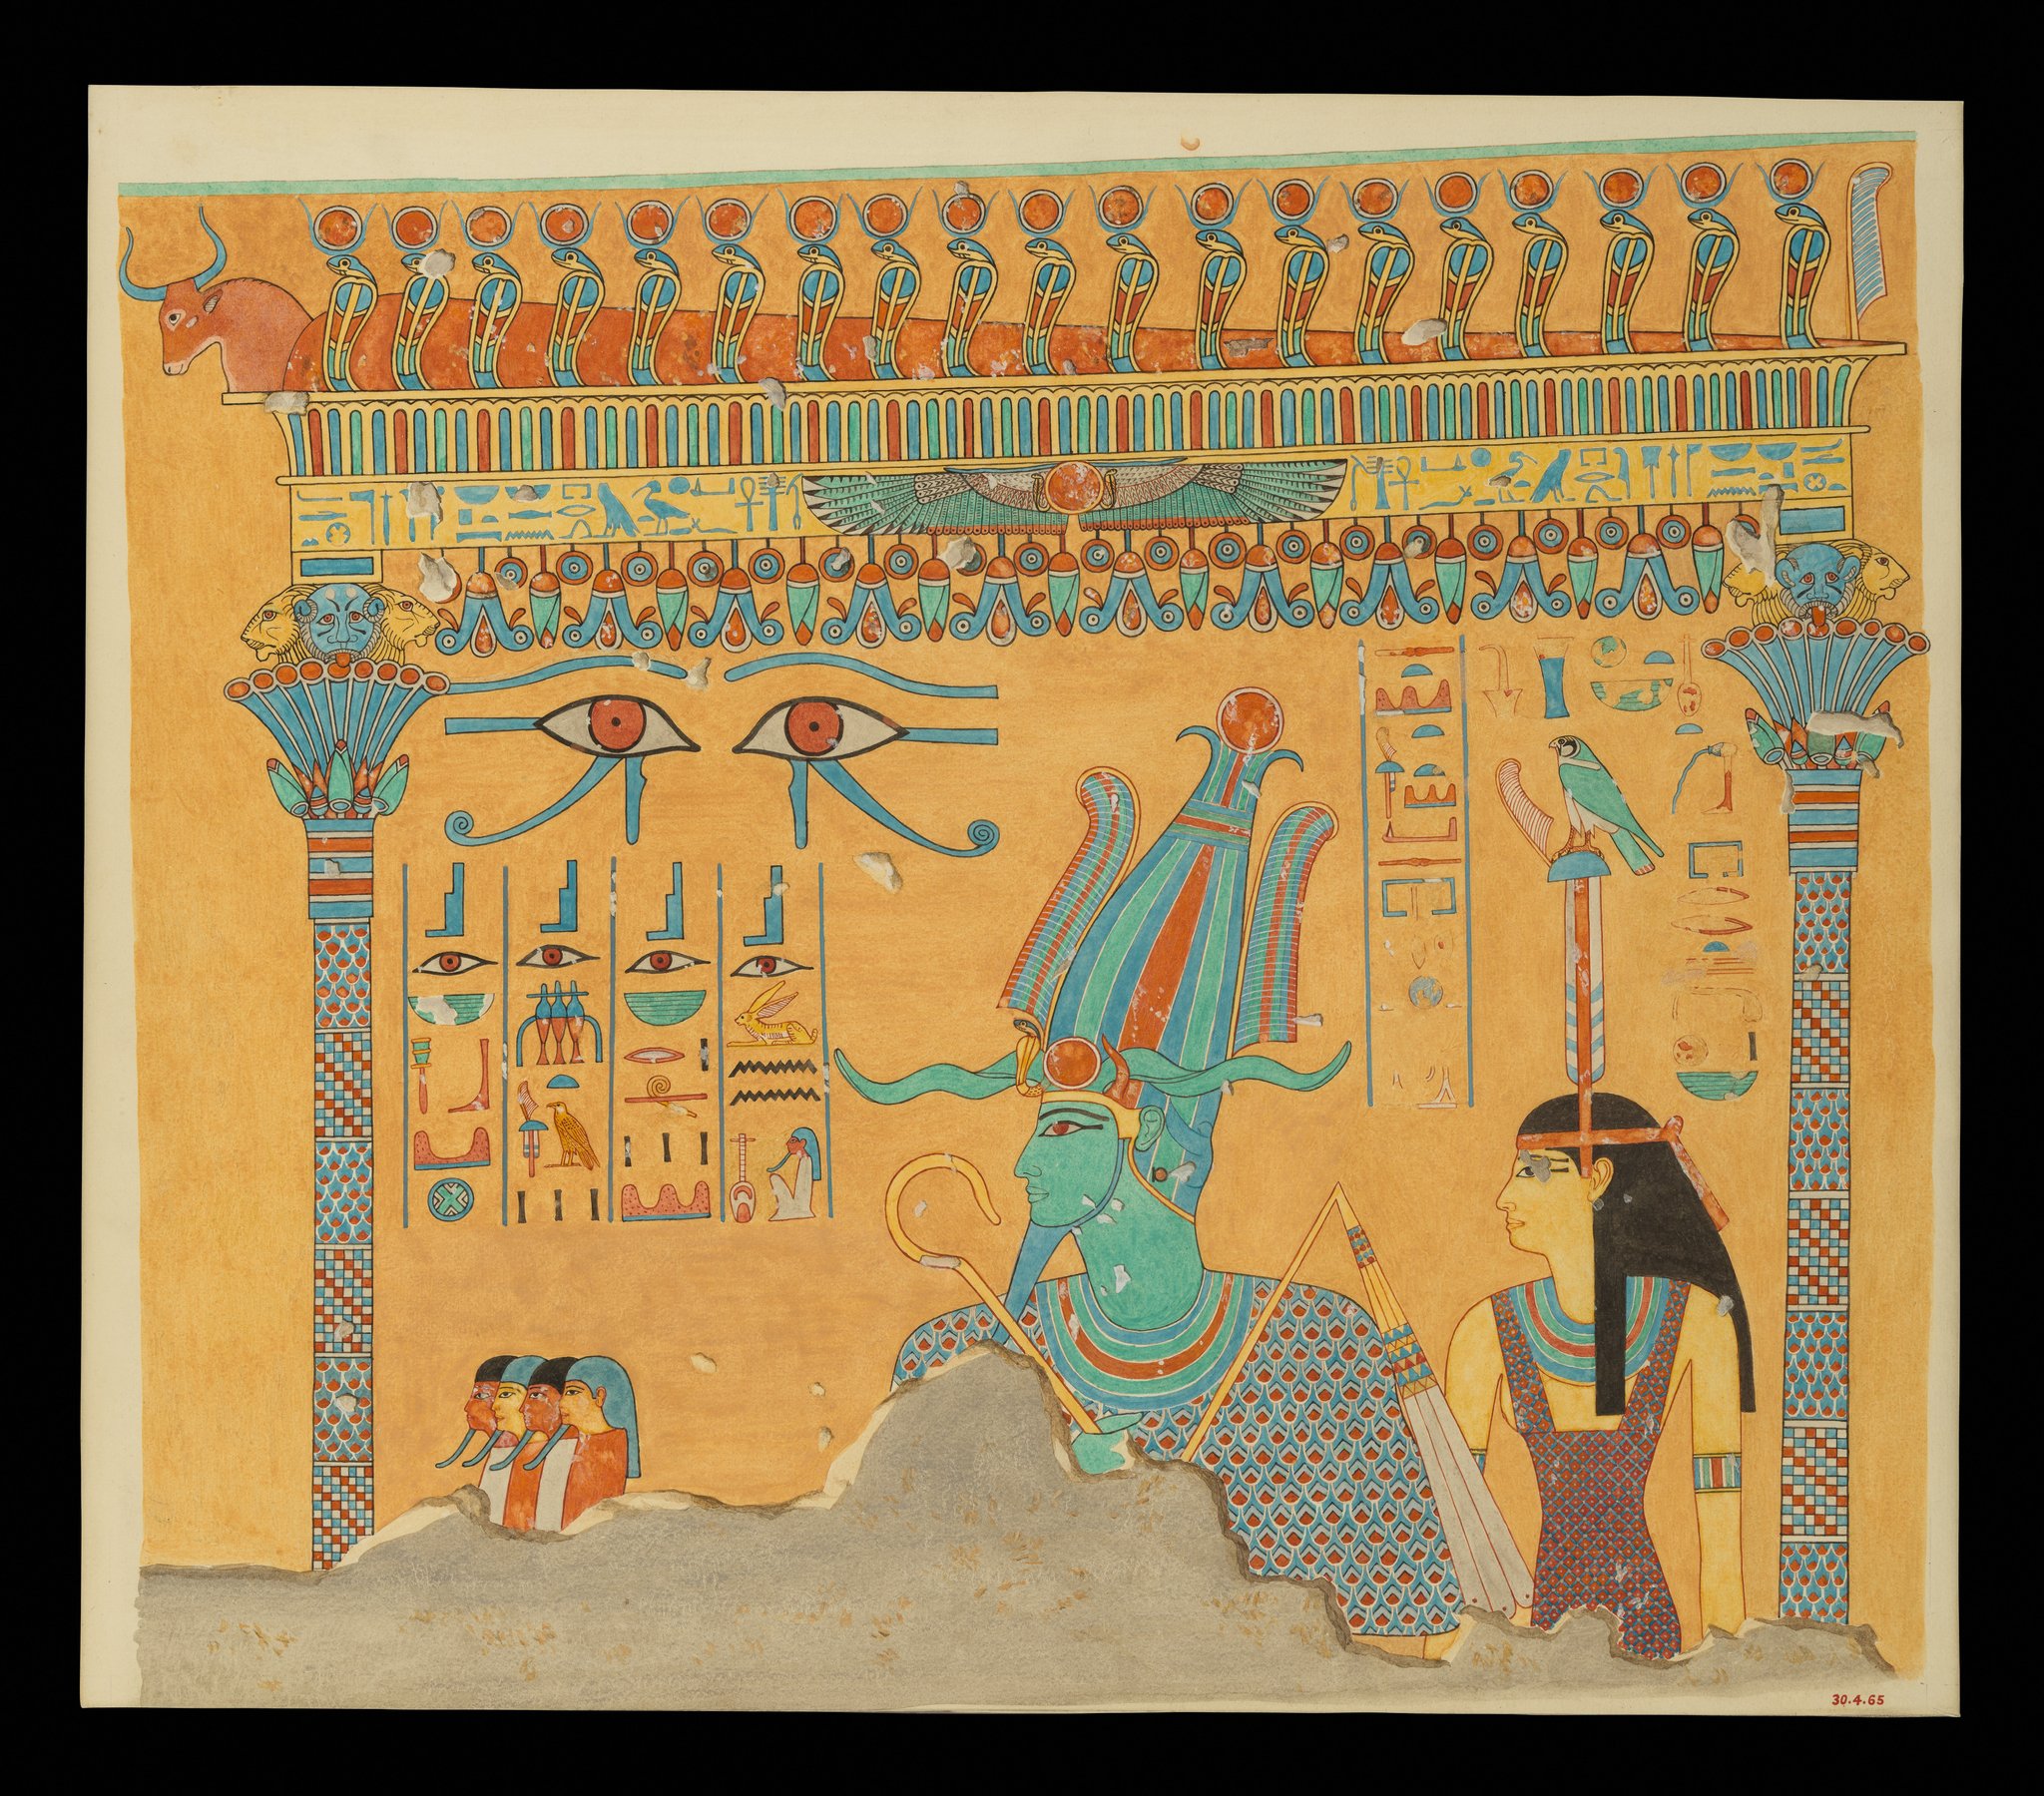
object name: facsimile, qenamun tt 93, osiris, goddess of west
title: Osiris and the Goddess of the West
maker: hugh r. hopgood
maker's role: artist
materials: paper, paint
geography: egypt